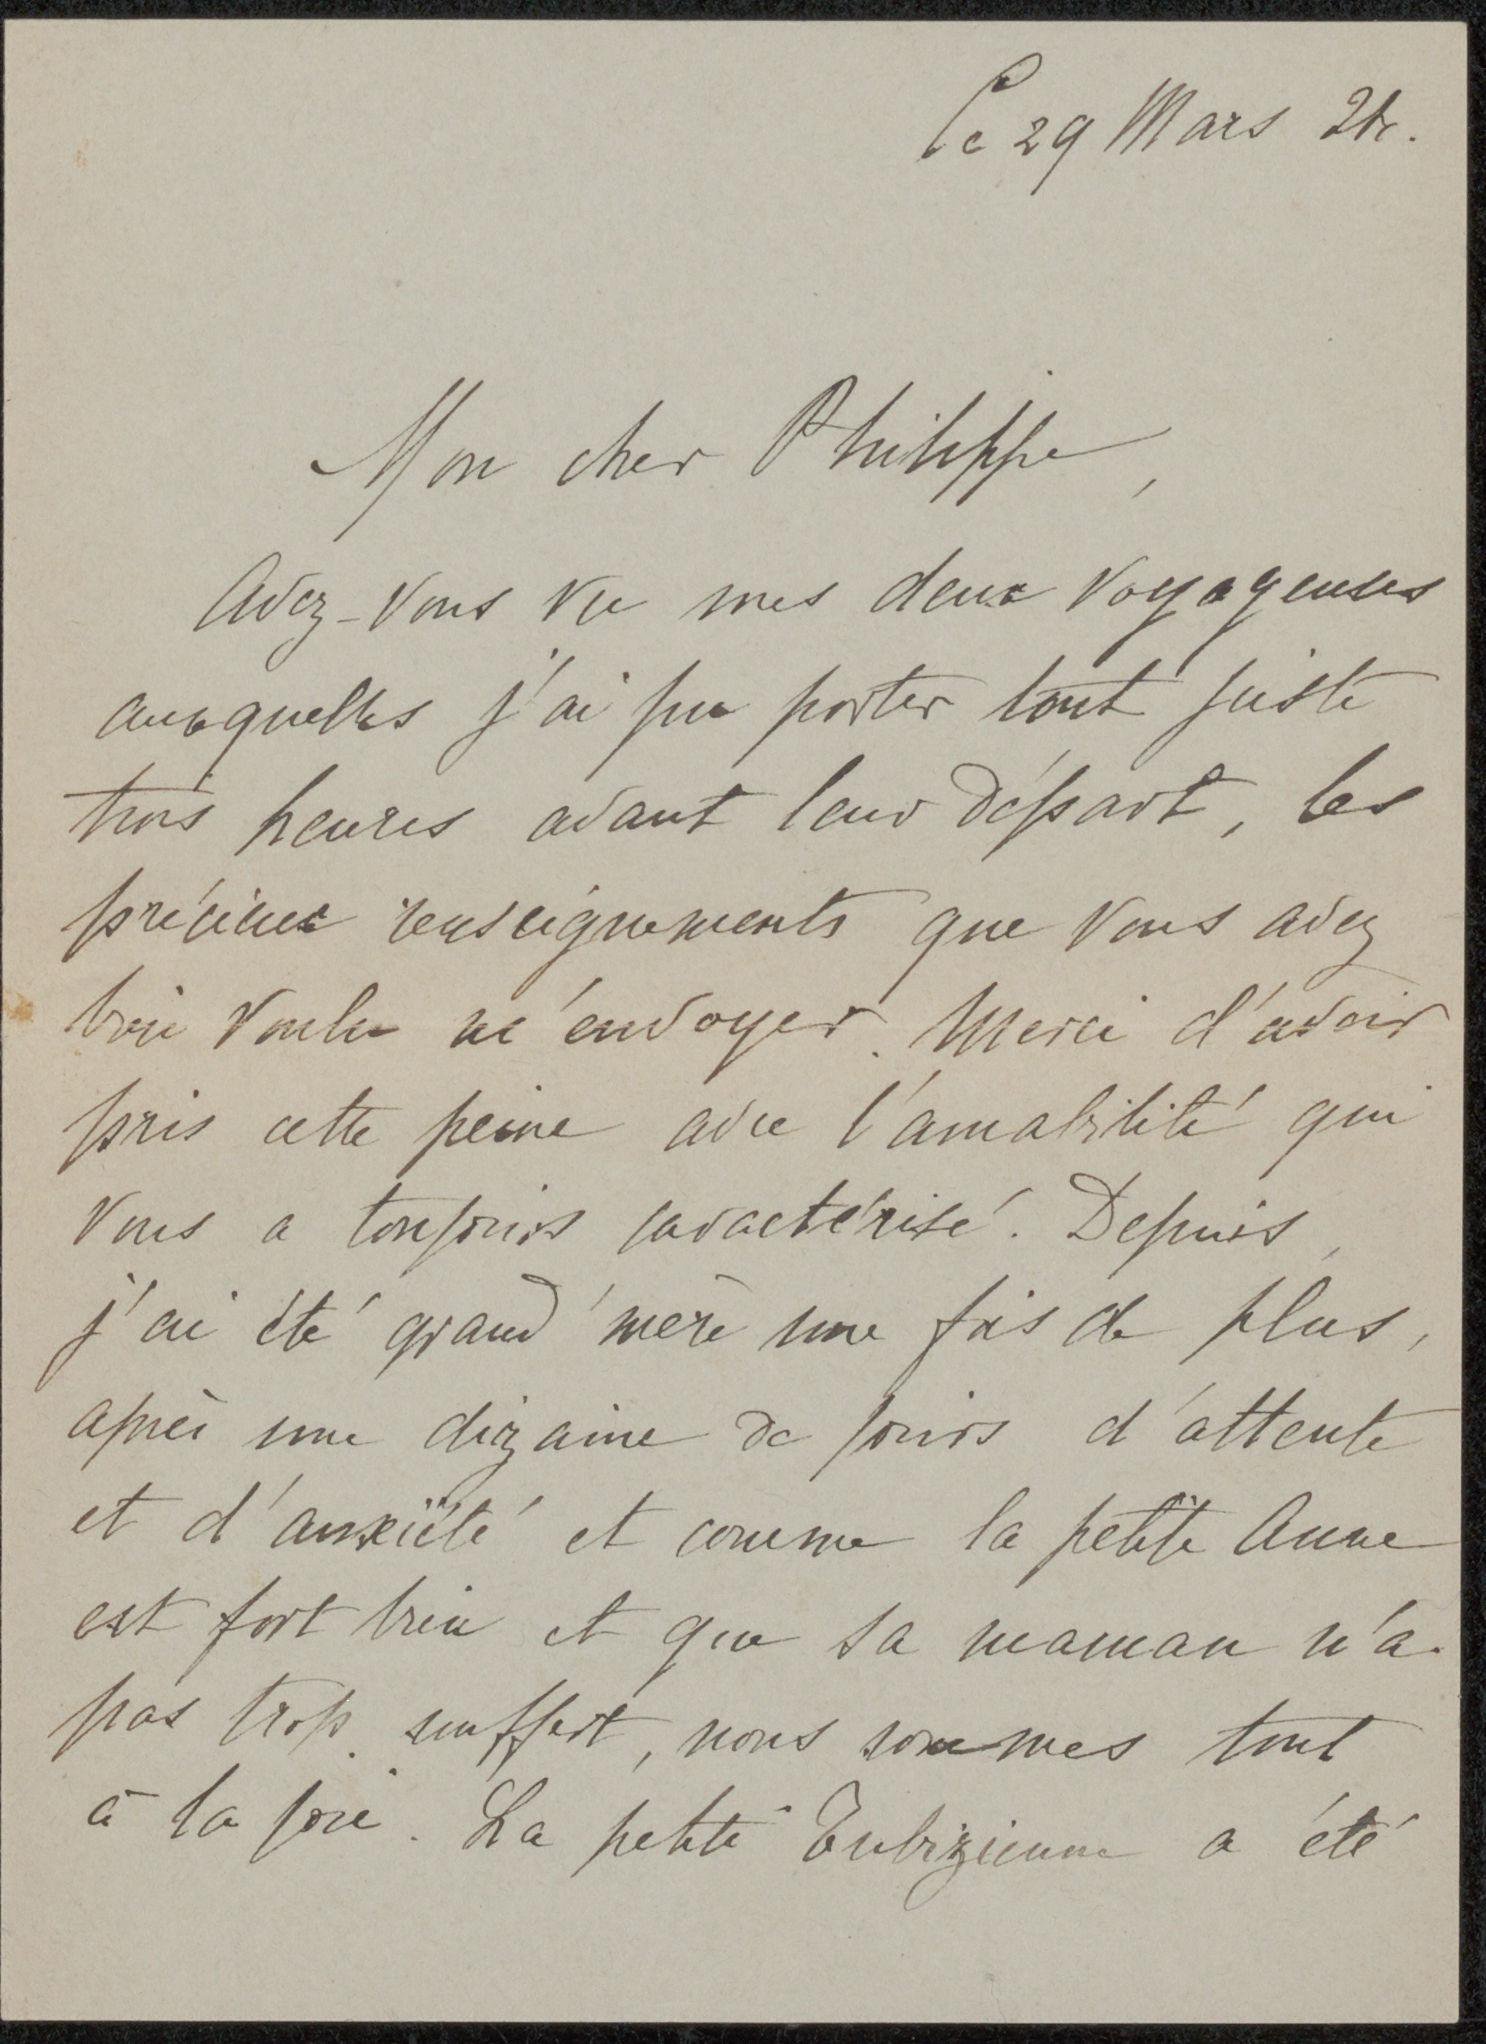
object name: letter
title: Brief aan Philip Zilcken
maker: jeanne boels de buck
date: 1924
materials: ink, paper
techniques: pen, writing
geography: brussels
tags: painter, draughtsman, philip zilcken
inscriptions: collector's mark: ‘RPK’